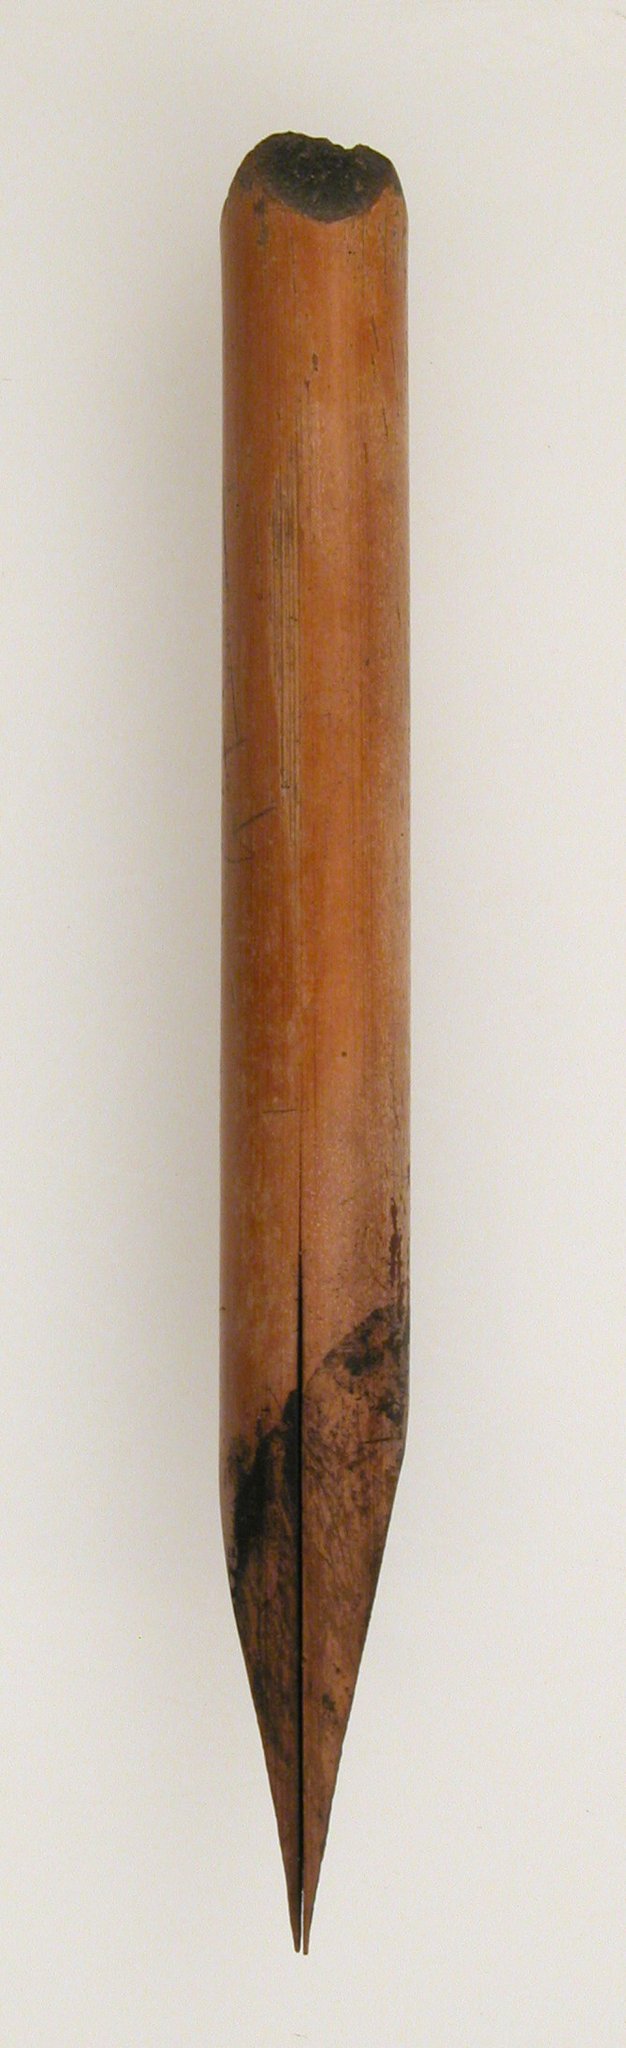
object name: pen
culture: coptic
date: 580-640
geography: egypt